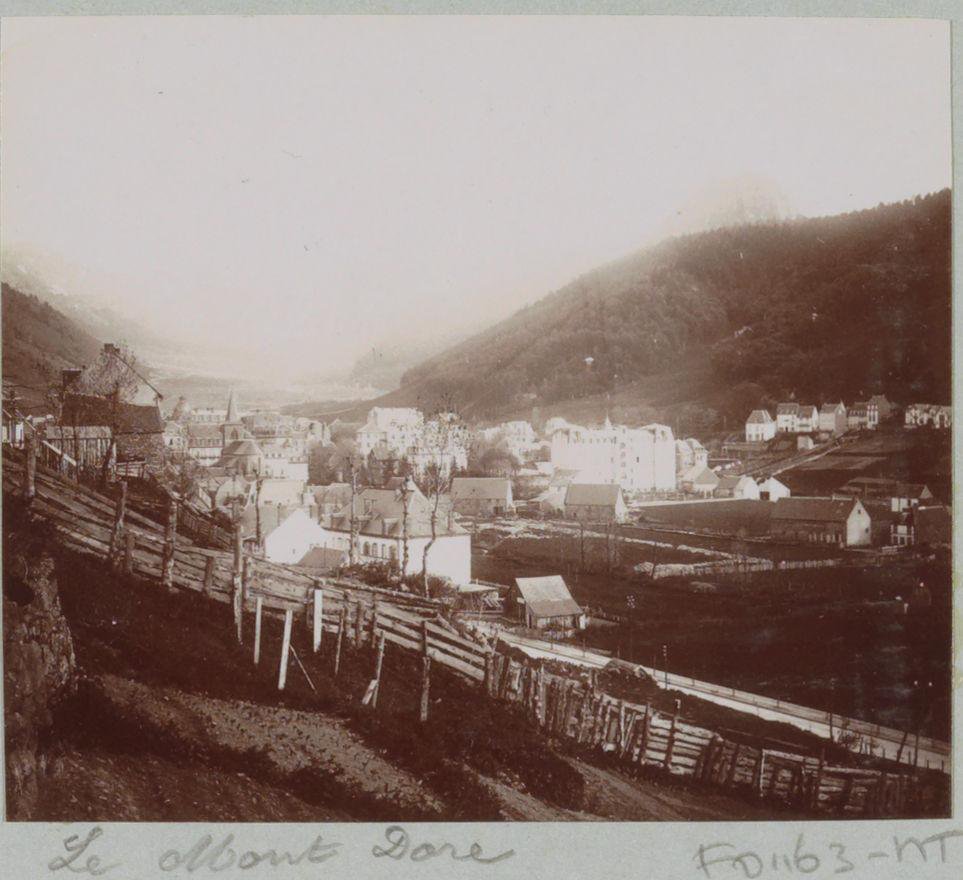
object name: photograph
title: Gezicht op Le Mont-Dore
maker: delizy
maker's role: manufacturer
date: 1902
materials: paper, photographic support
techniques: gelatin silver print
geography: mont-dore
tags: prospect of village, silhouette of village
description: Onderdeel van Fotoalbum van een Franse amateurfotograaf met opnames van uitstapjes in Frankrijk, Spanje, België, Luxemburg en Nederland, de eerste automobielen en autoraces.